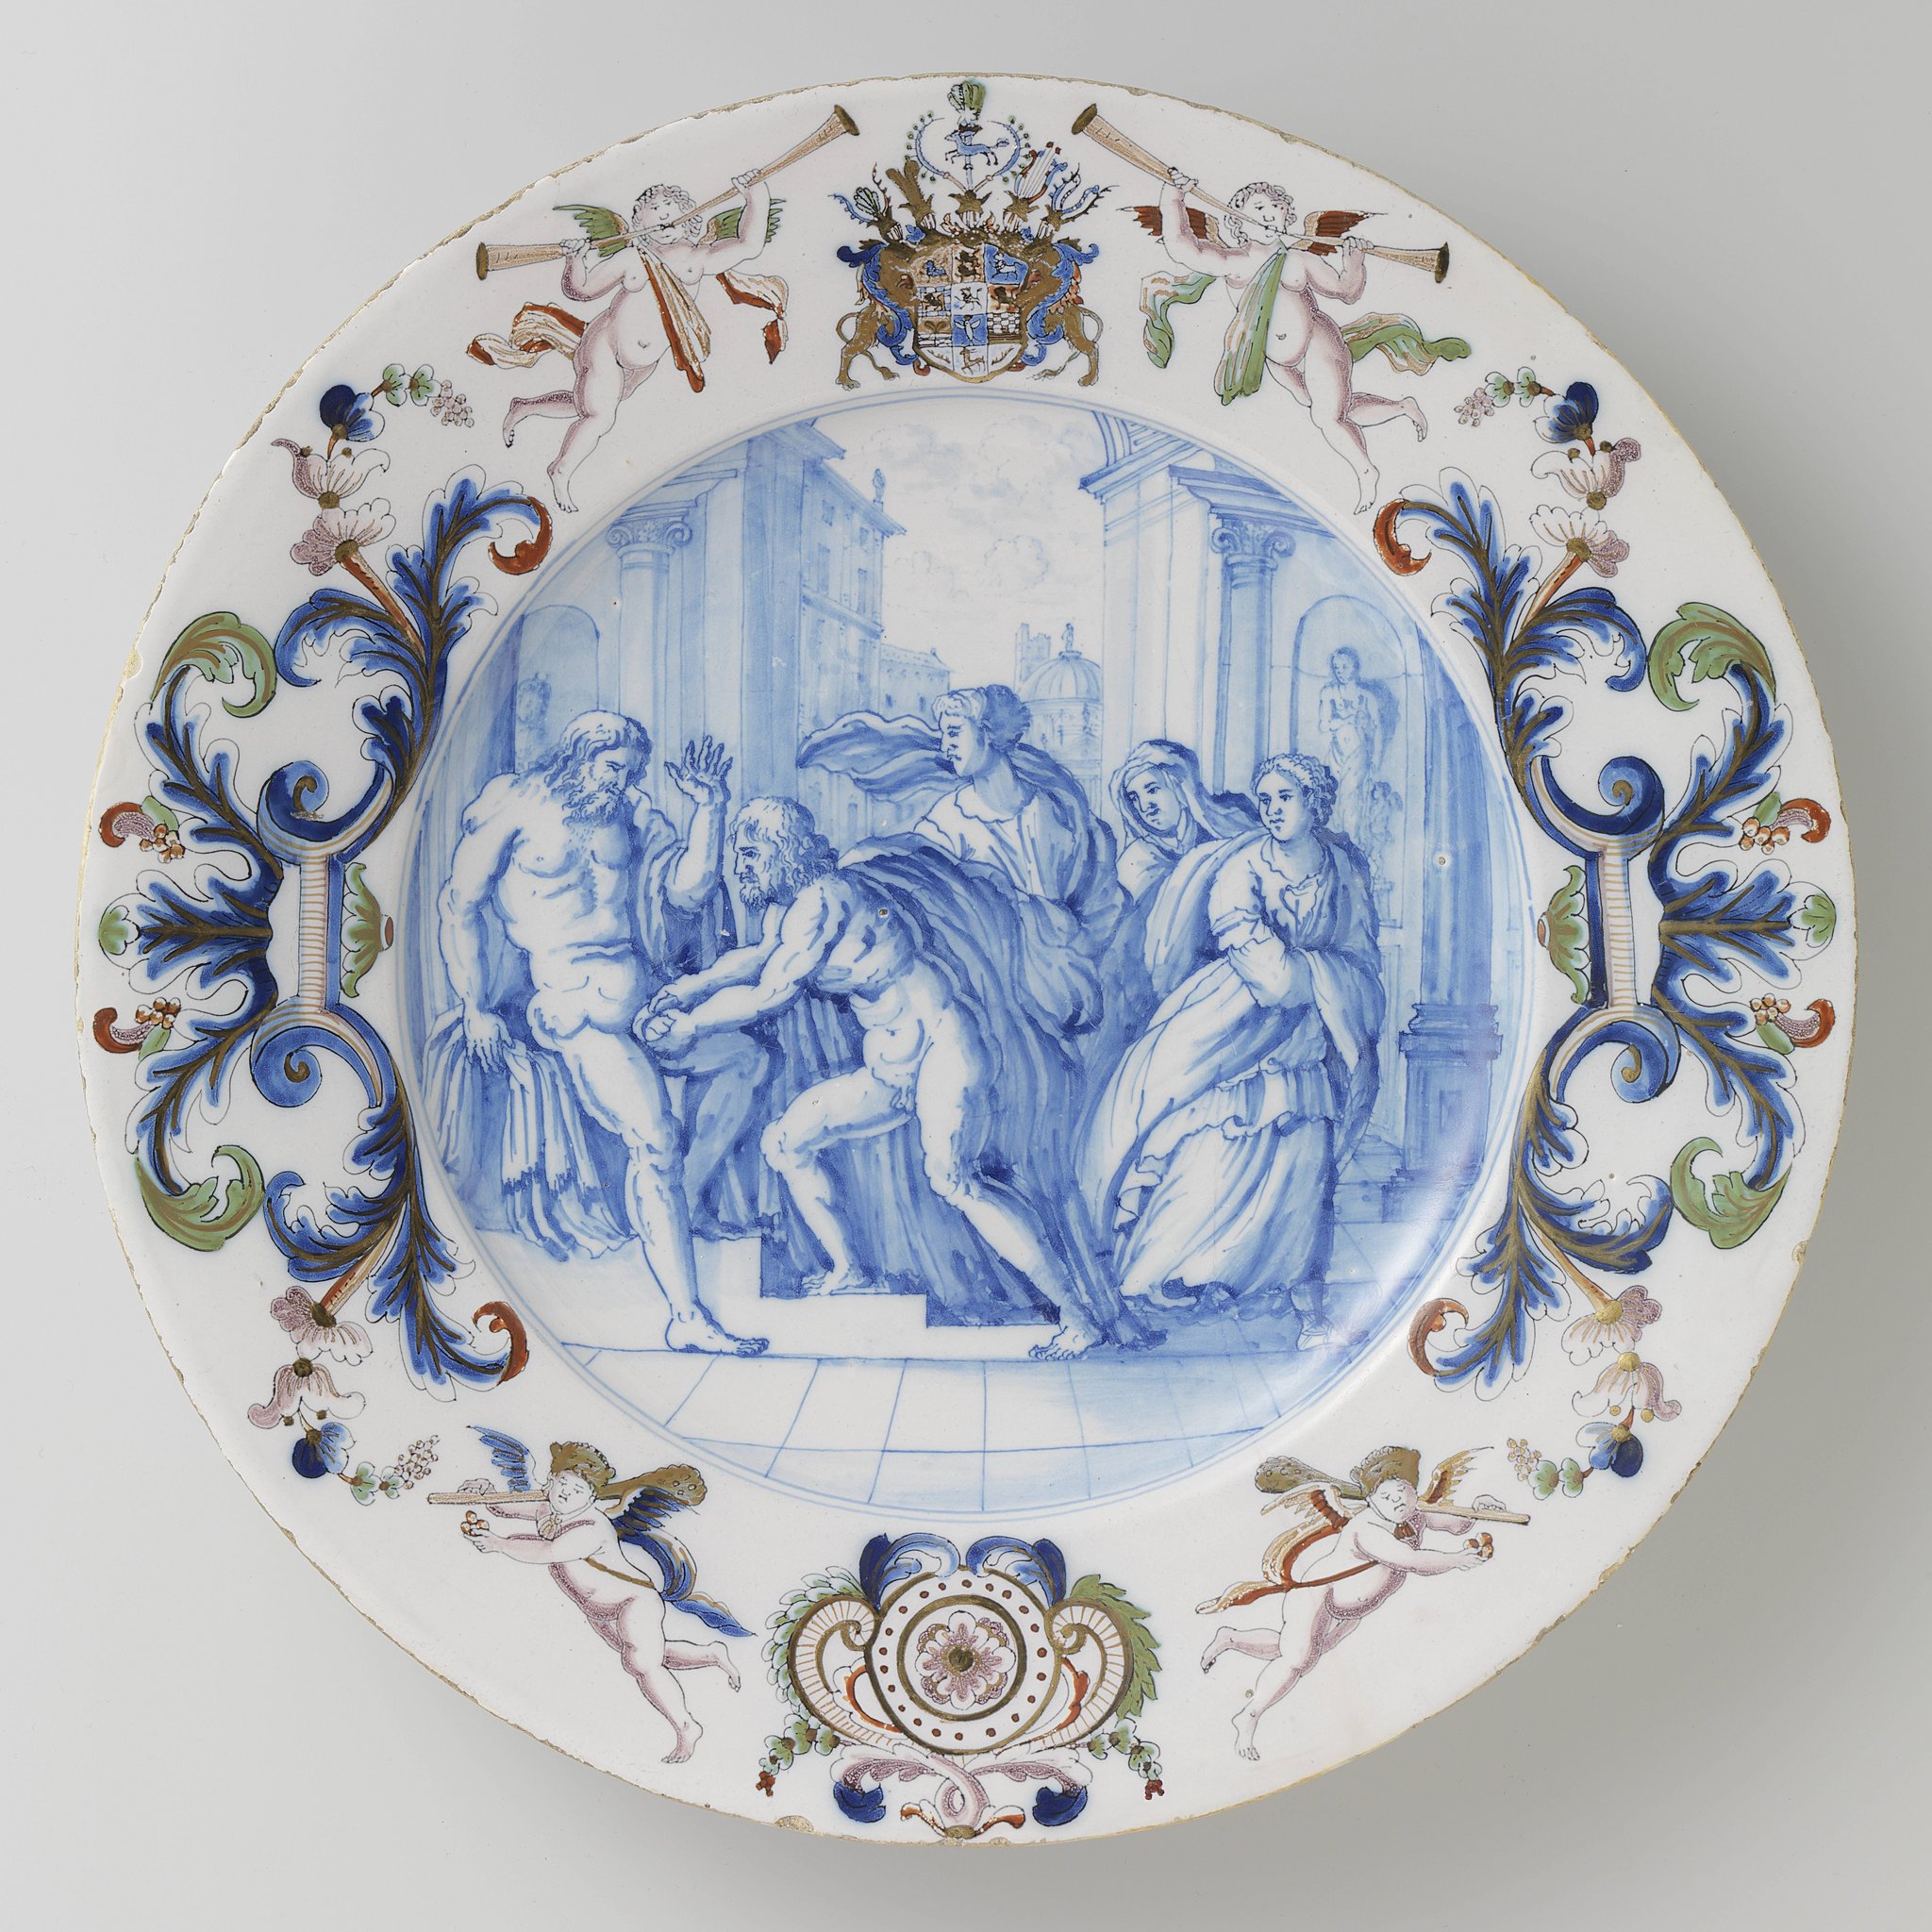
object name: platter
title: Dish with the Castration of Uranus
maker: jannitge claesdr hoppesteijn-van straten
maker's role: plateelbakker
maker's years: -1686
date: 1680-1685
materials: earthenware, glaze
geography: delft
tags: uranus (caelus), heaven (+ suffering, misfortune), (story of) saturn (cronus)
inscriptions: mark: ‘IW(ineen)’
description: Around 1680 the Moriaanshooft pottery factory in Delft succeeded in producing painted decorations in a variety of colours, as can be seen in the edge of this dish. Such objects with ornamented edges and Classical scenes were very much in vogue among the European elite. This dish bears the arms of the Duchess of Braunschweig and Lüneburg, and may have been a wedding gift.